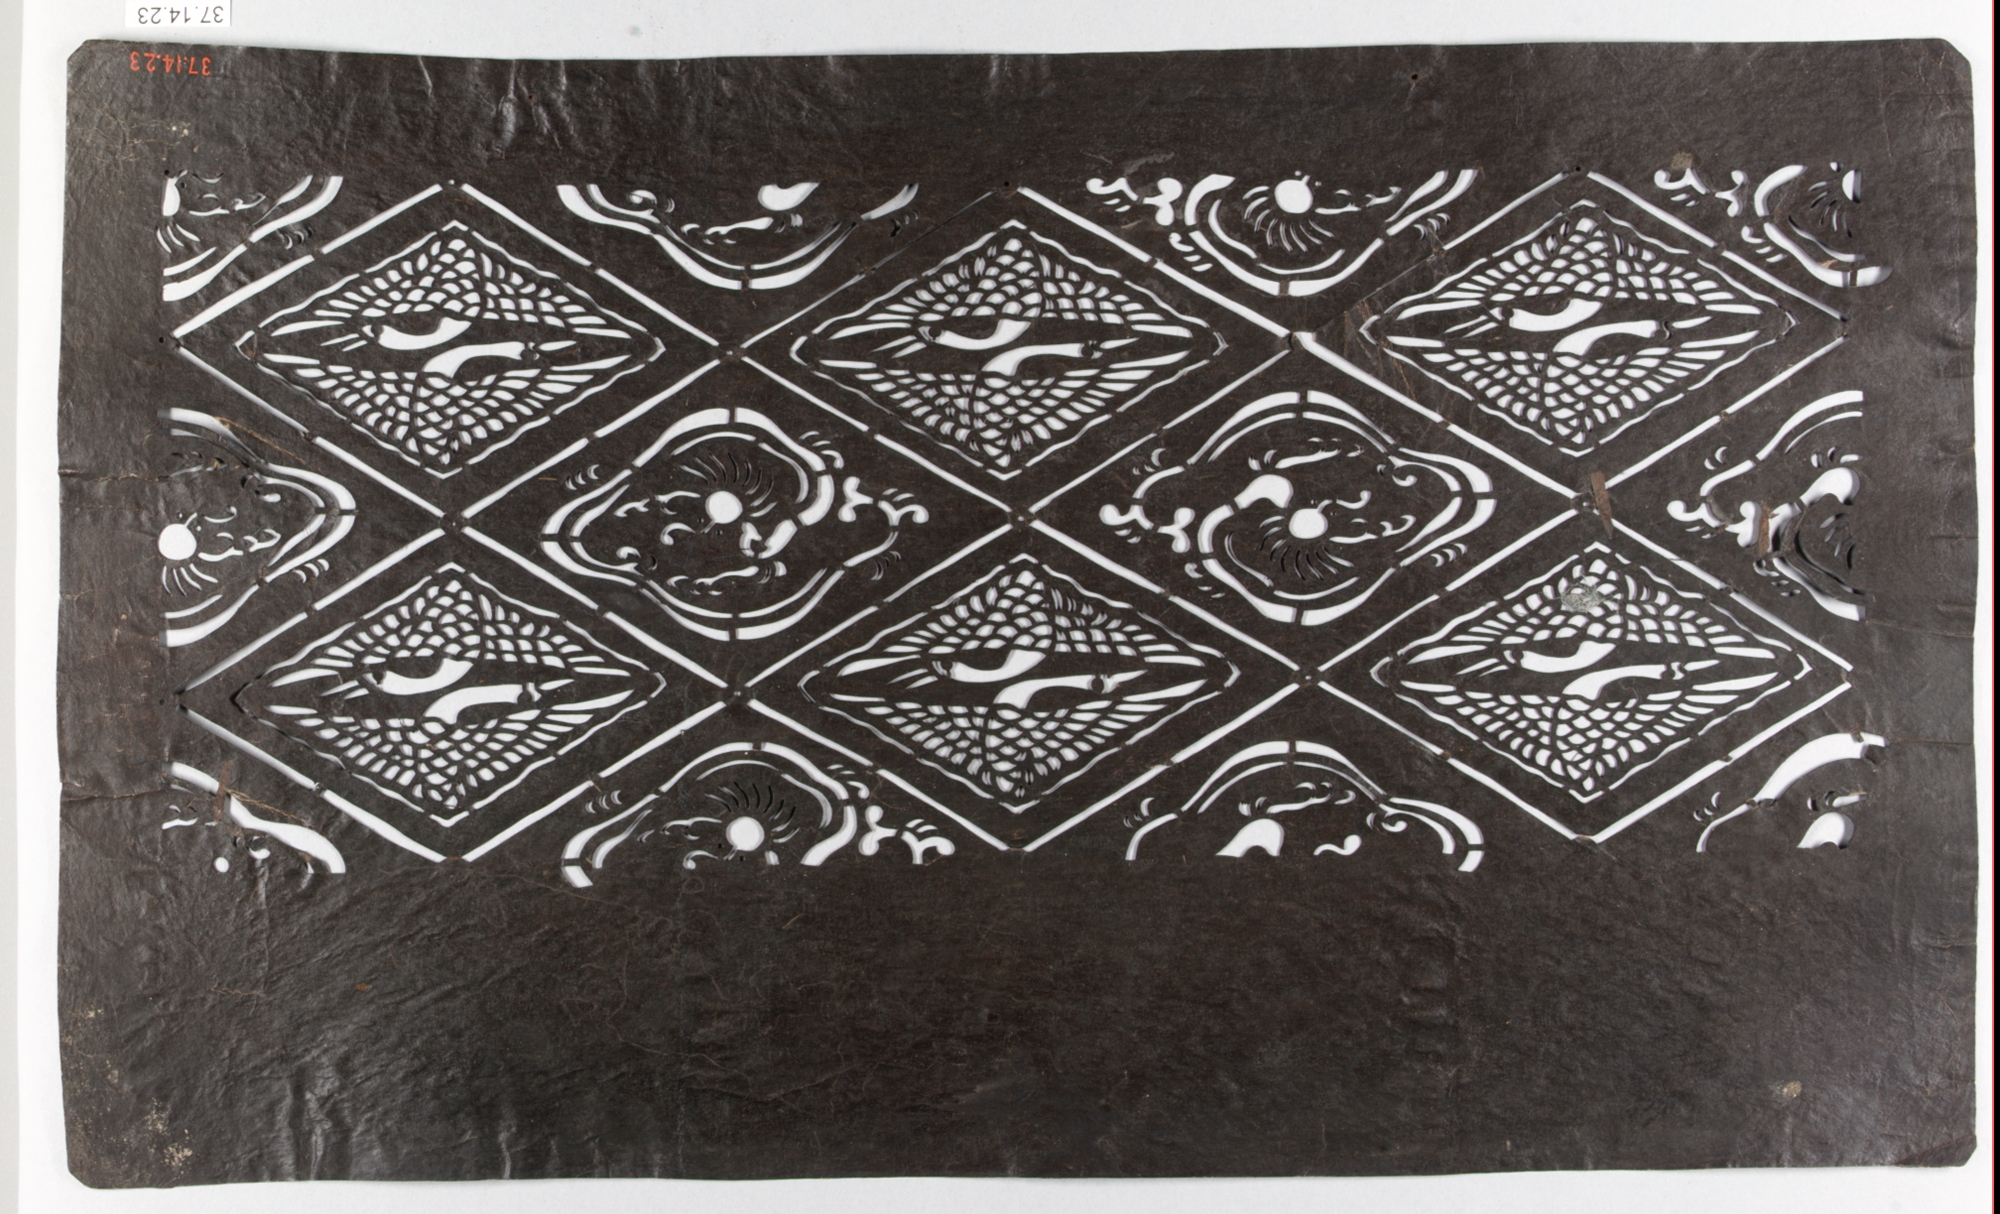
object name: stencil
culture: japanese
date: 1801-1833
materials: paper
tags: birds